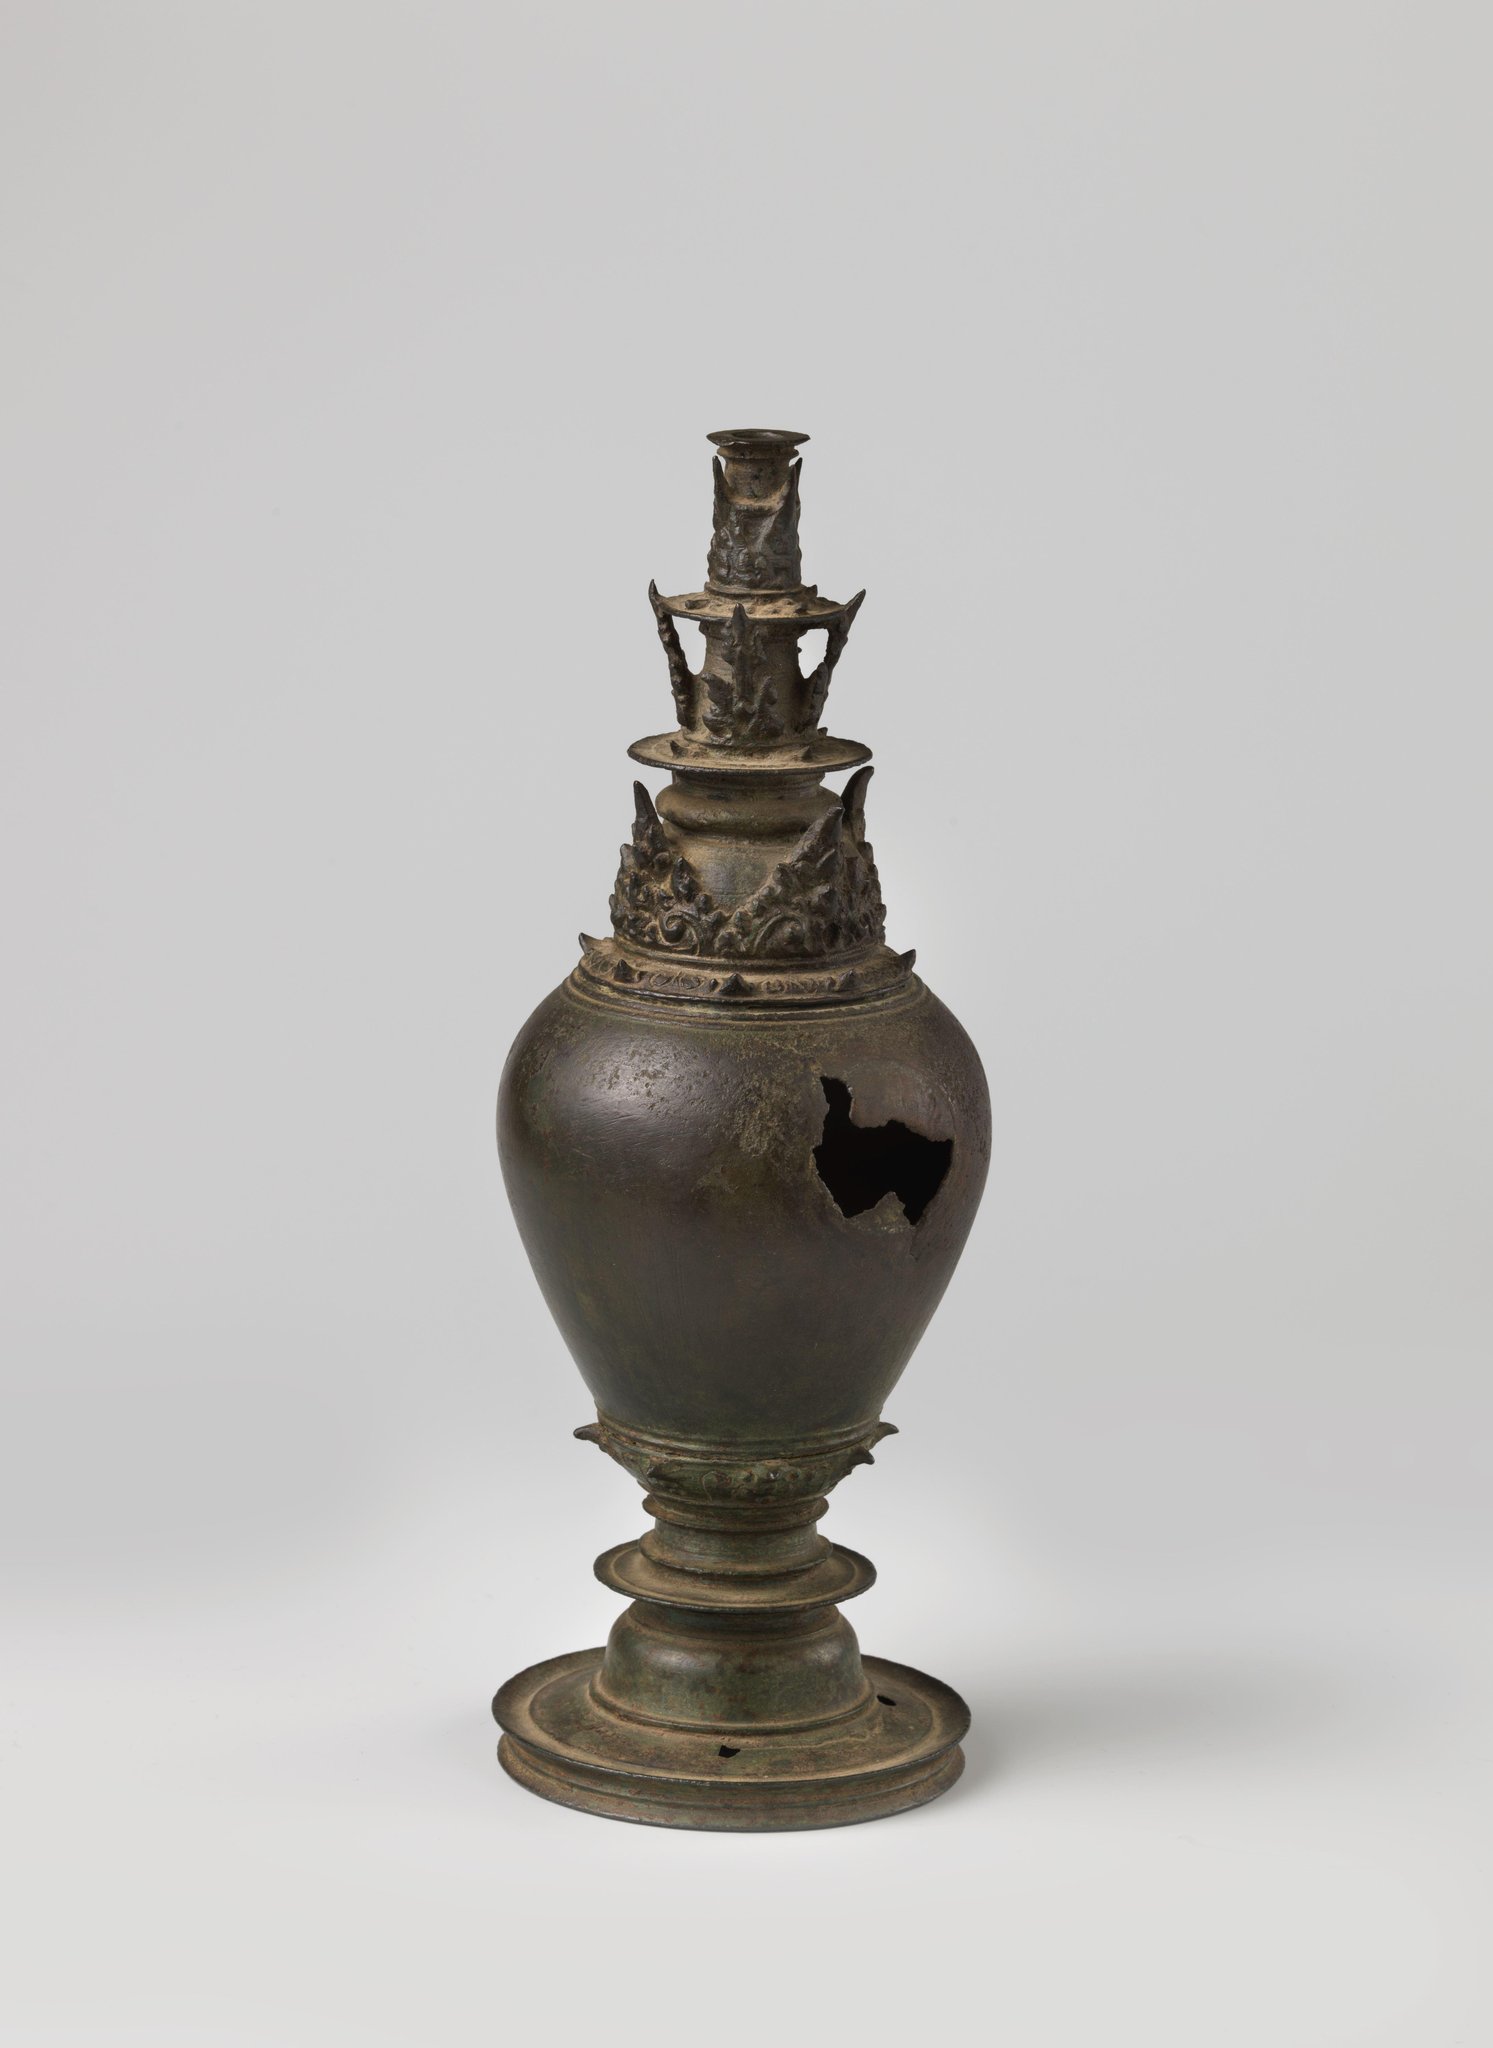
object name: religious ritual object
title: Kan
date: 1200-1499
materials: bronze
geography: java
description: Bronzen kan voor levenselixer. De tuit op de schouder ontbreekt.